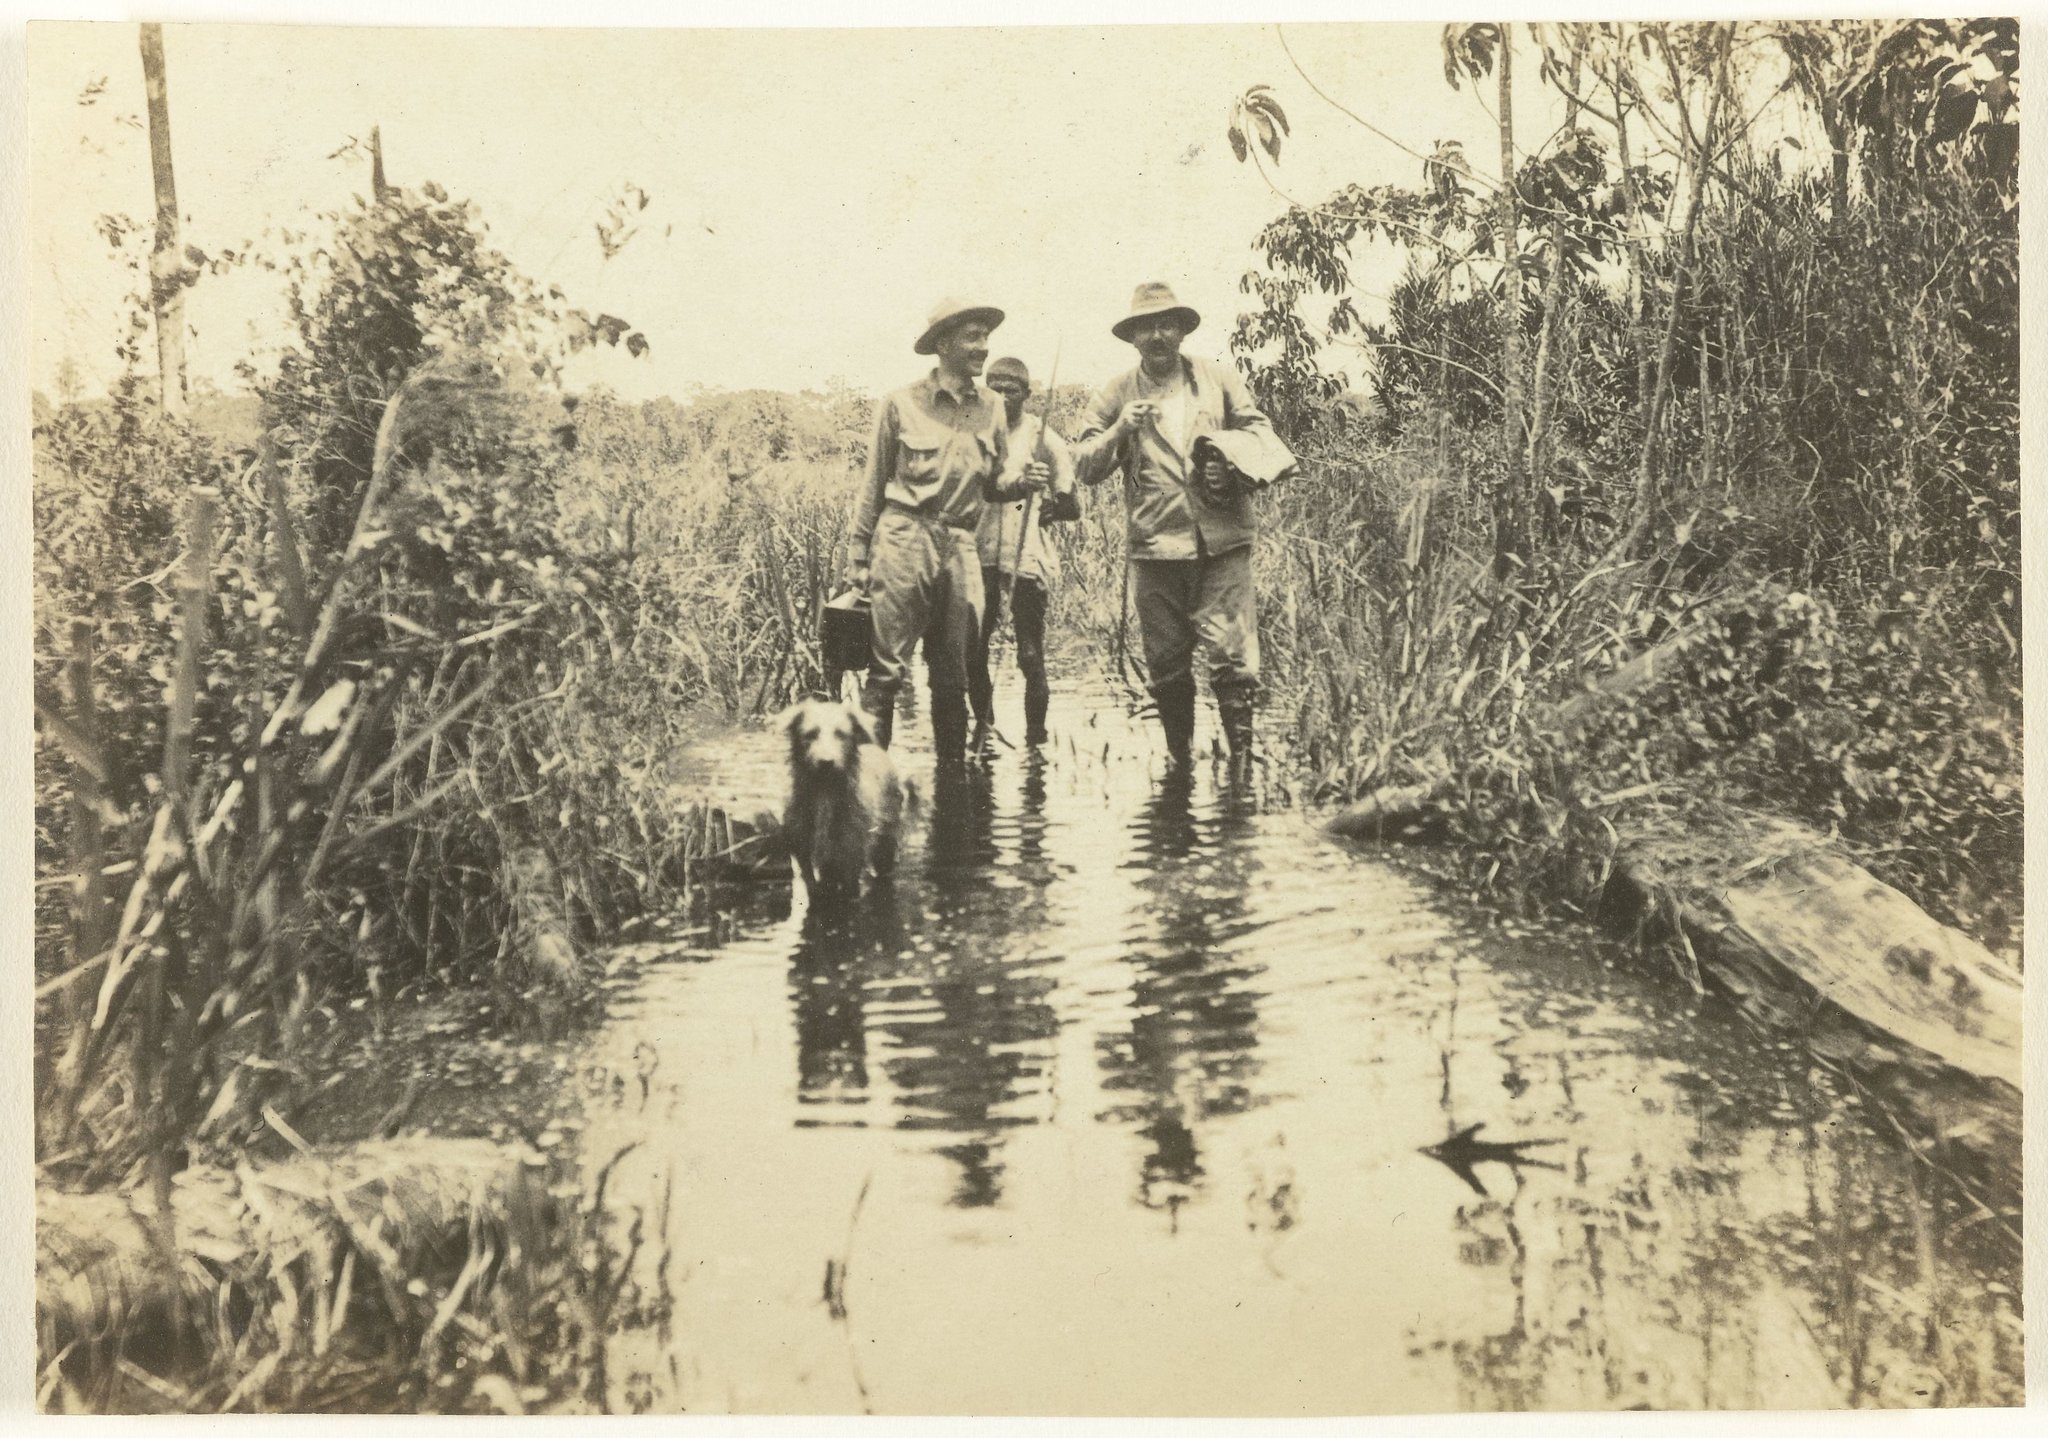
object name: photograph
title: Op pad op terrein van plantage Accaribo te Suriname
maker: Anonymous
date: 1916-1930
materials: photographic support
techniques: photography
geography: suriname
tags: amsterdam, theodoor brouwers, plantation, suriname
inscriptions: inscription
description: In de periode 1911-1932 woonde op plantage Accaribo in Suriname de familie Brouwers van wie de foto's afkomstig zijn. Rond 1910 vond Theodoor Brouwers werk op plantage Accaribo. In 1929 werd hij eigenaar van de plantage.